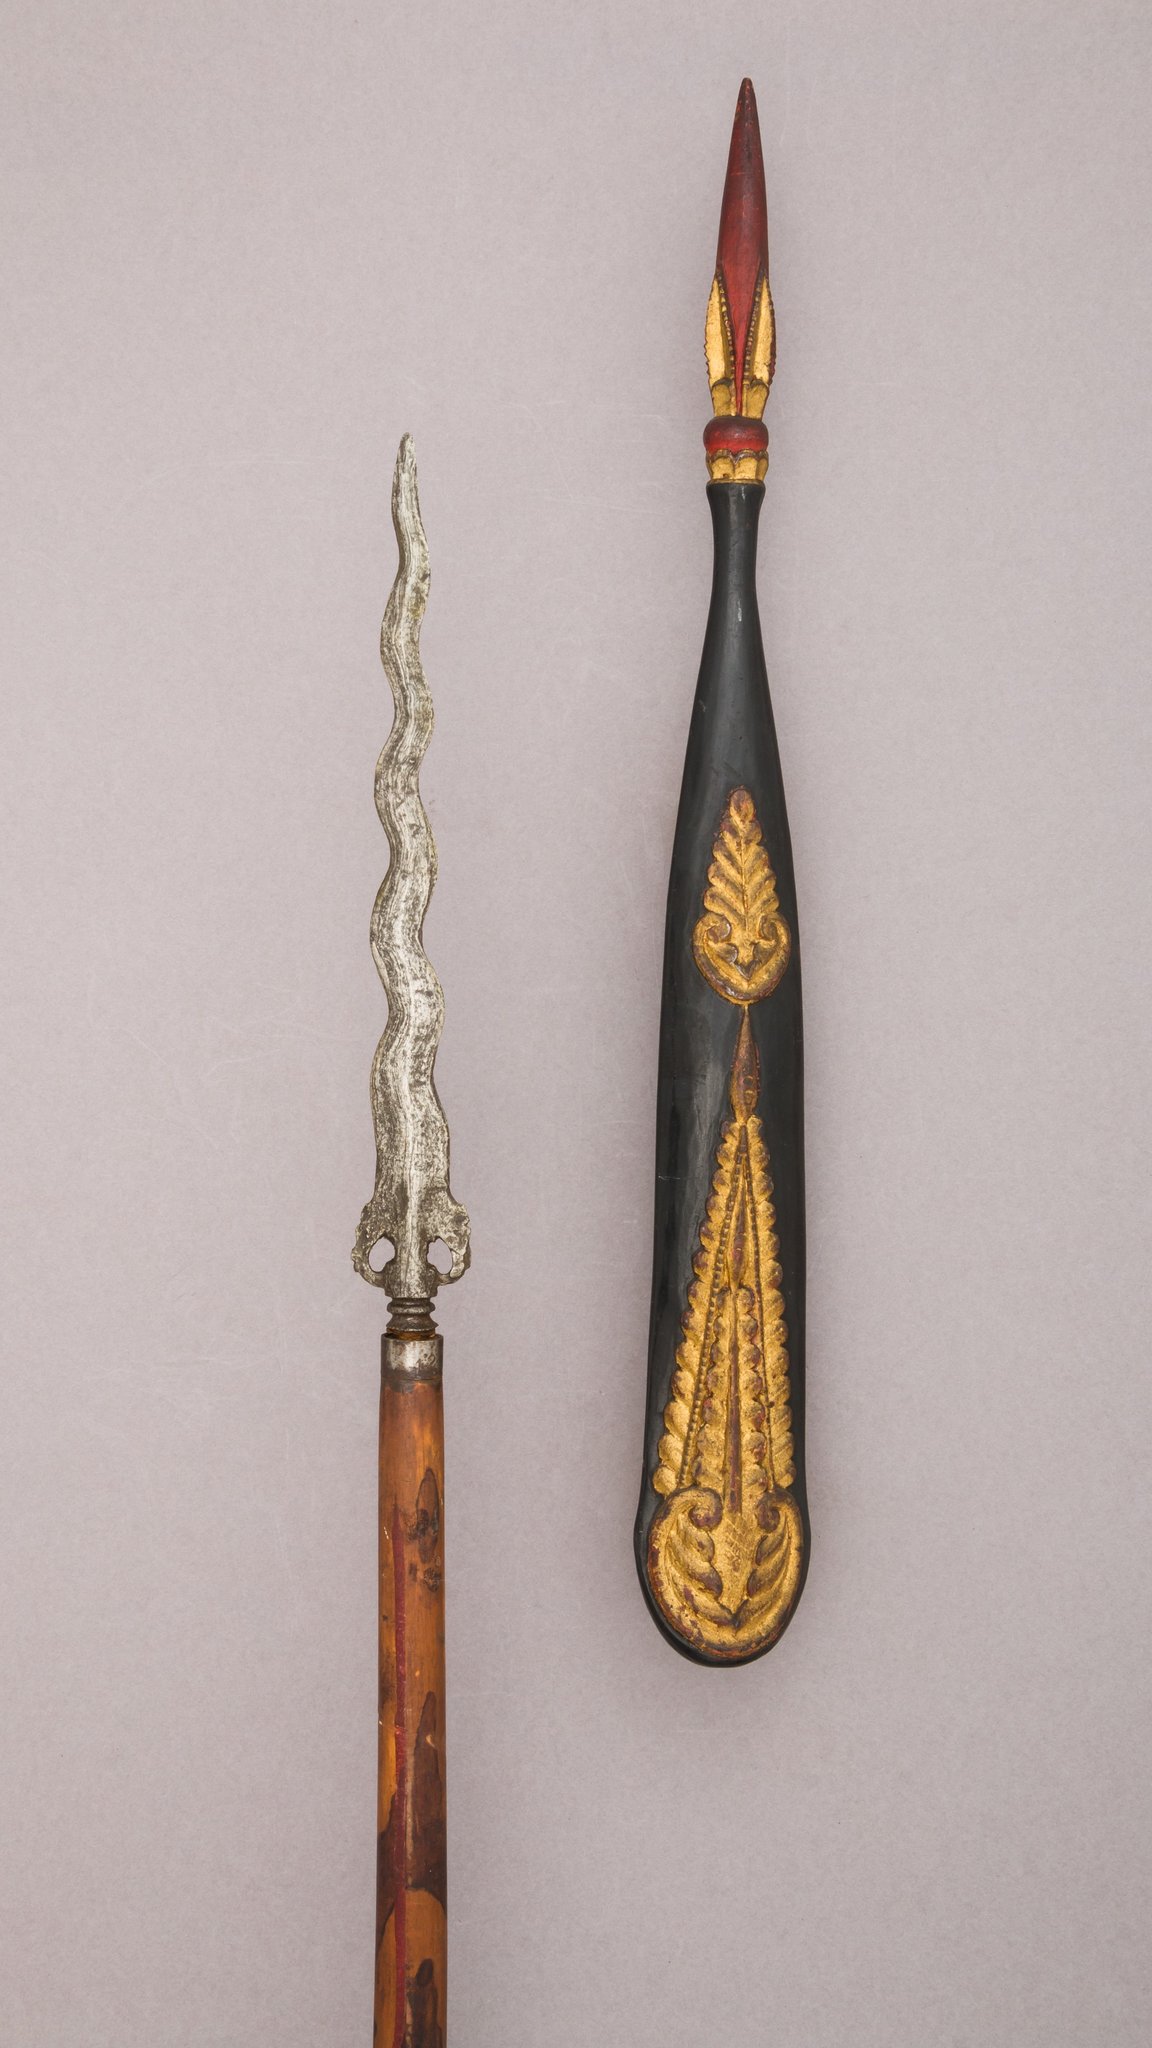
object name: spear with sheath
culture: balinese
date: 1501-1900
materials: wood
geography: indonesia